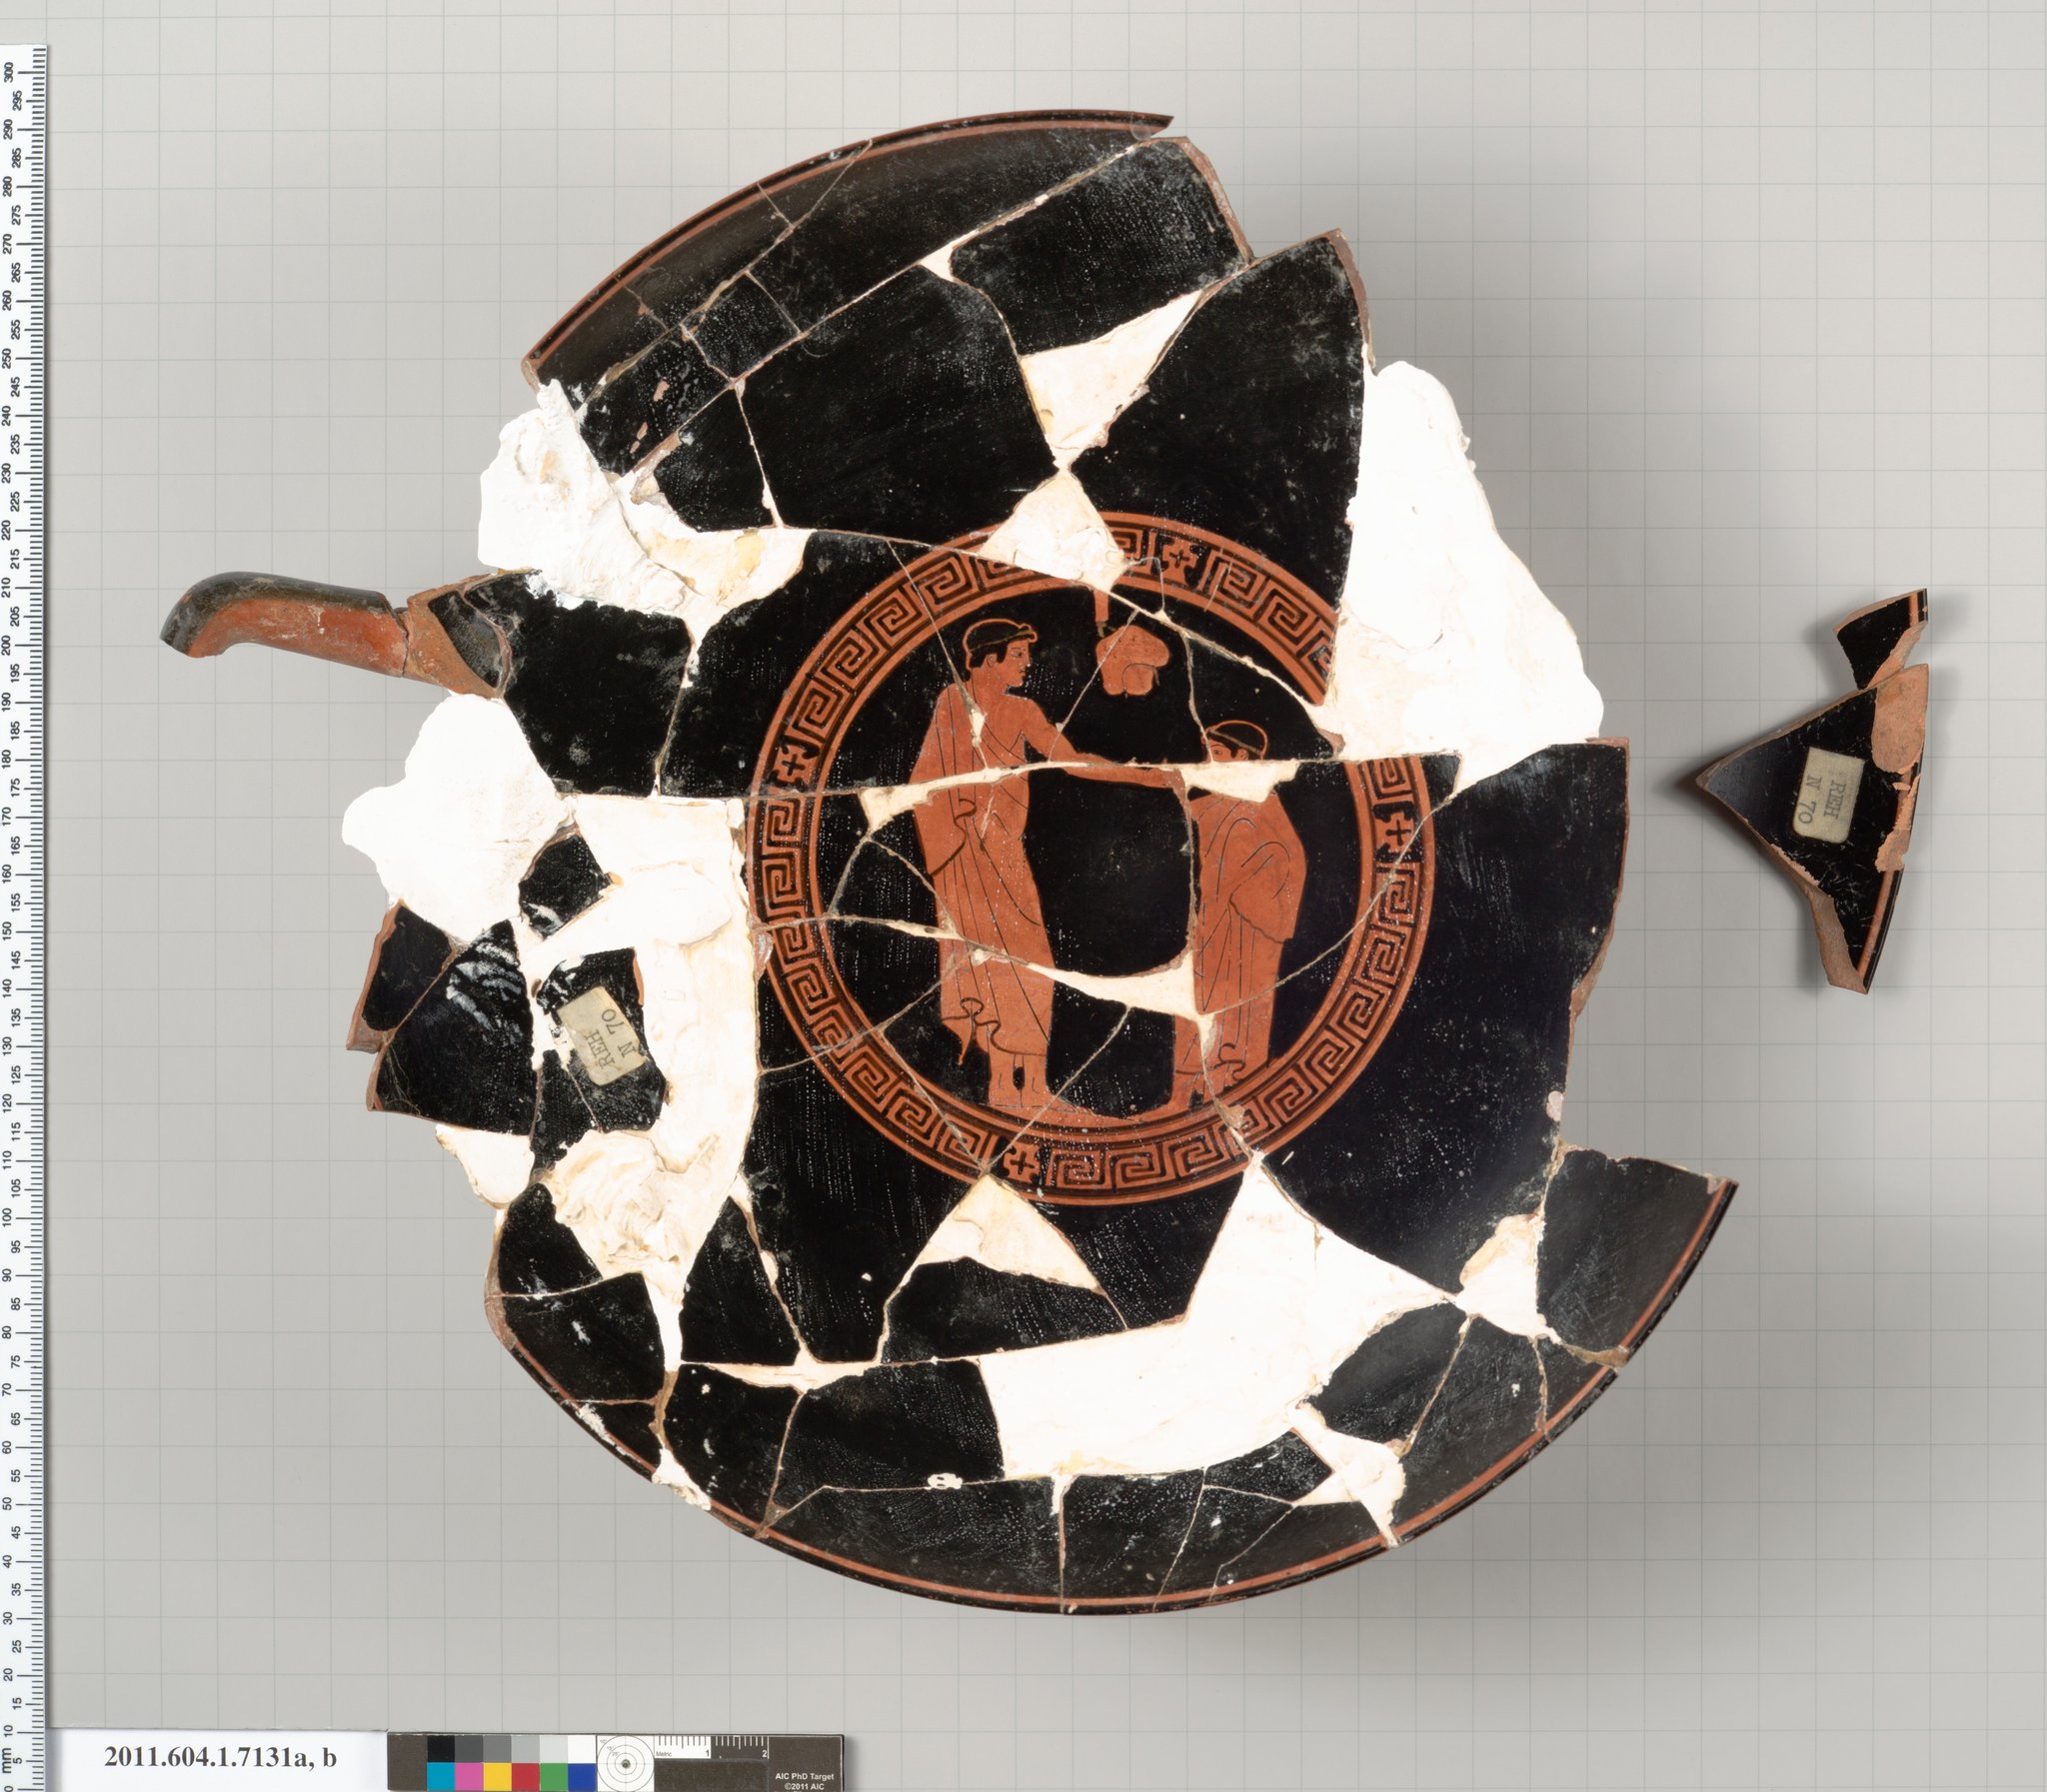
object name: kylix fragment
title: Terracotta fragments of a kylix (drinking cup)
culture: greek, attic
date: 475-451 BCE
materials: terracotta